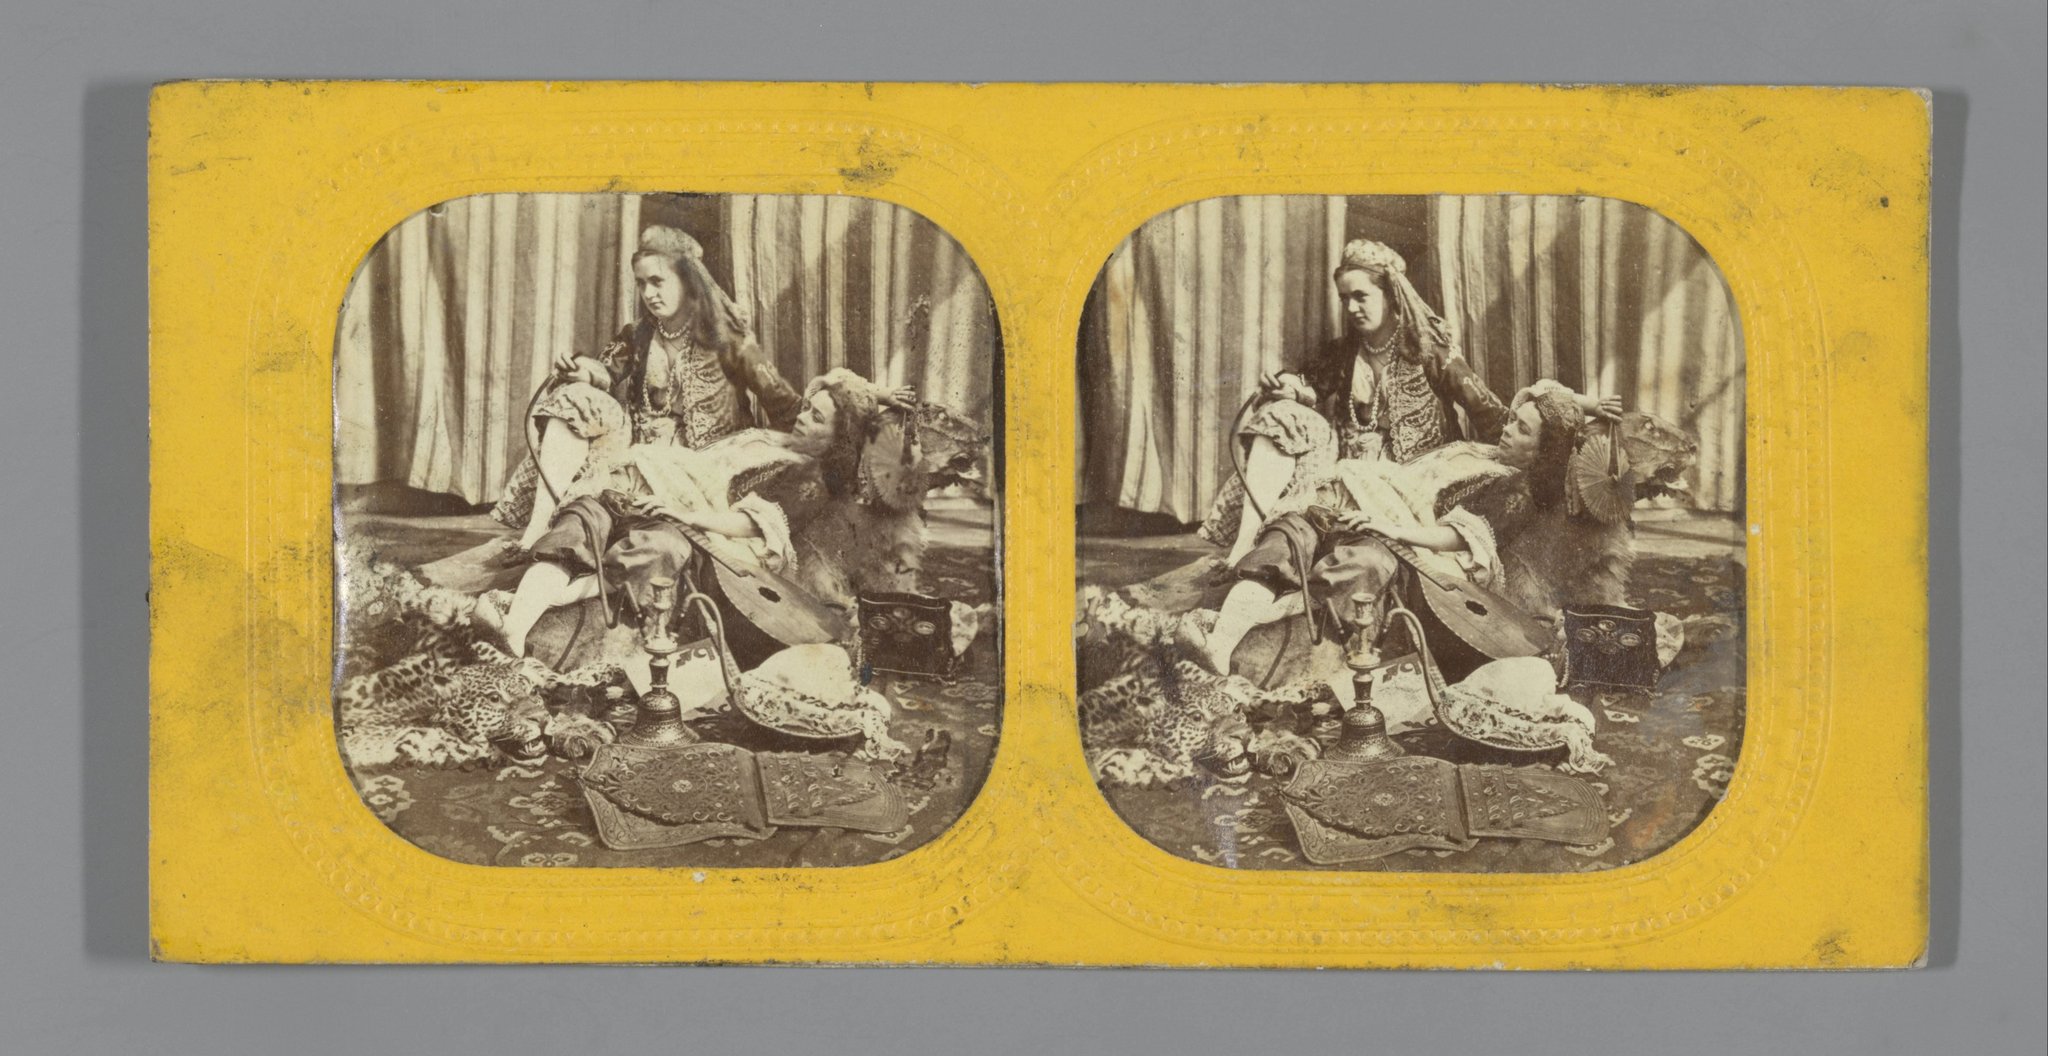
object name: stereograph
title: Twee vrouwen met waterpijp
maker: Anonymous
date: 1855-1875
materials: cardboard, paper, photographic support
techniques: albumen print, hand coloring, perforating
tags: water-pipe, hookah, narghile